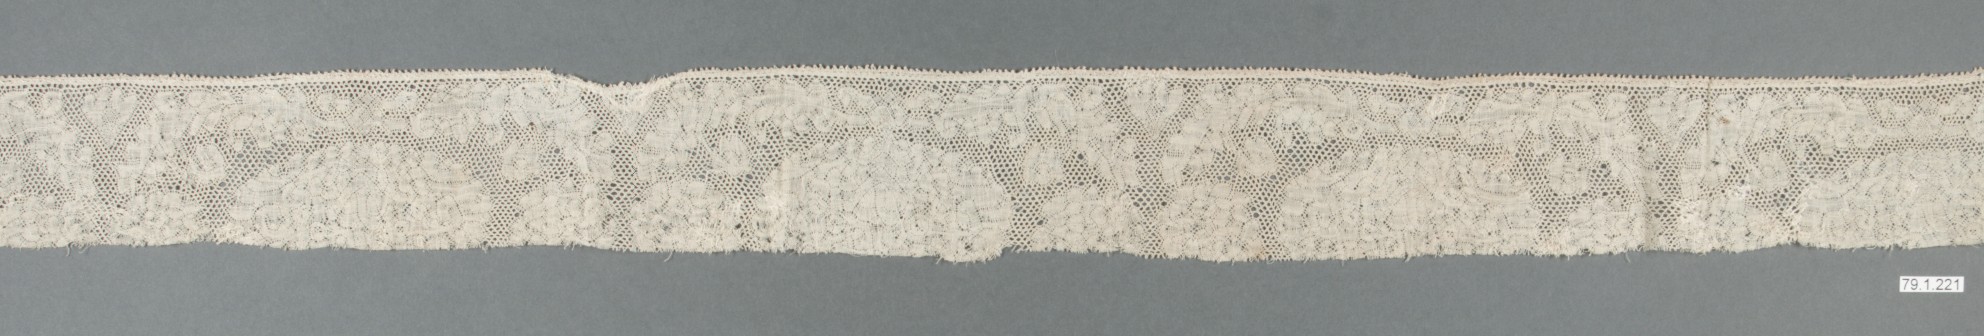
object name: strip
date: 1601-1800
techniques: lace